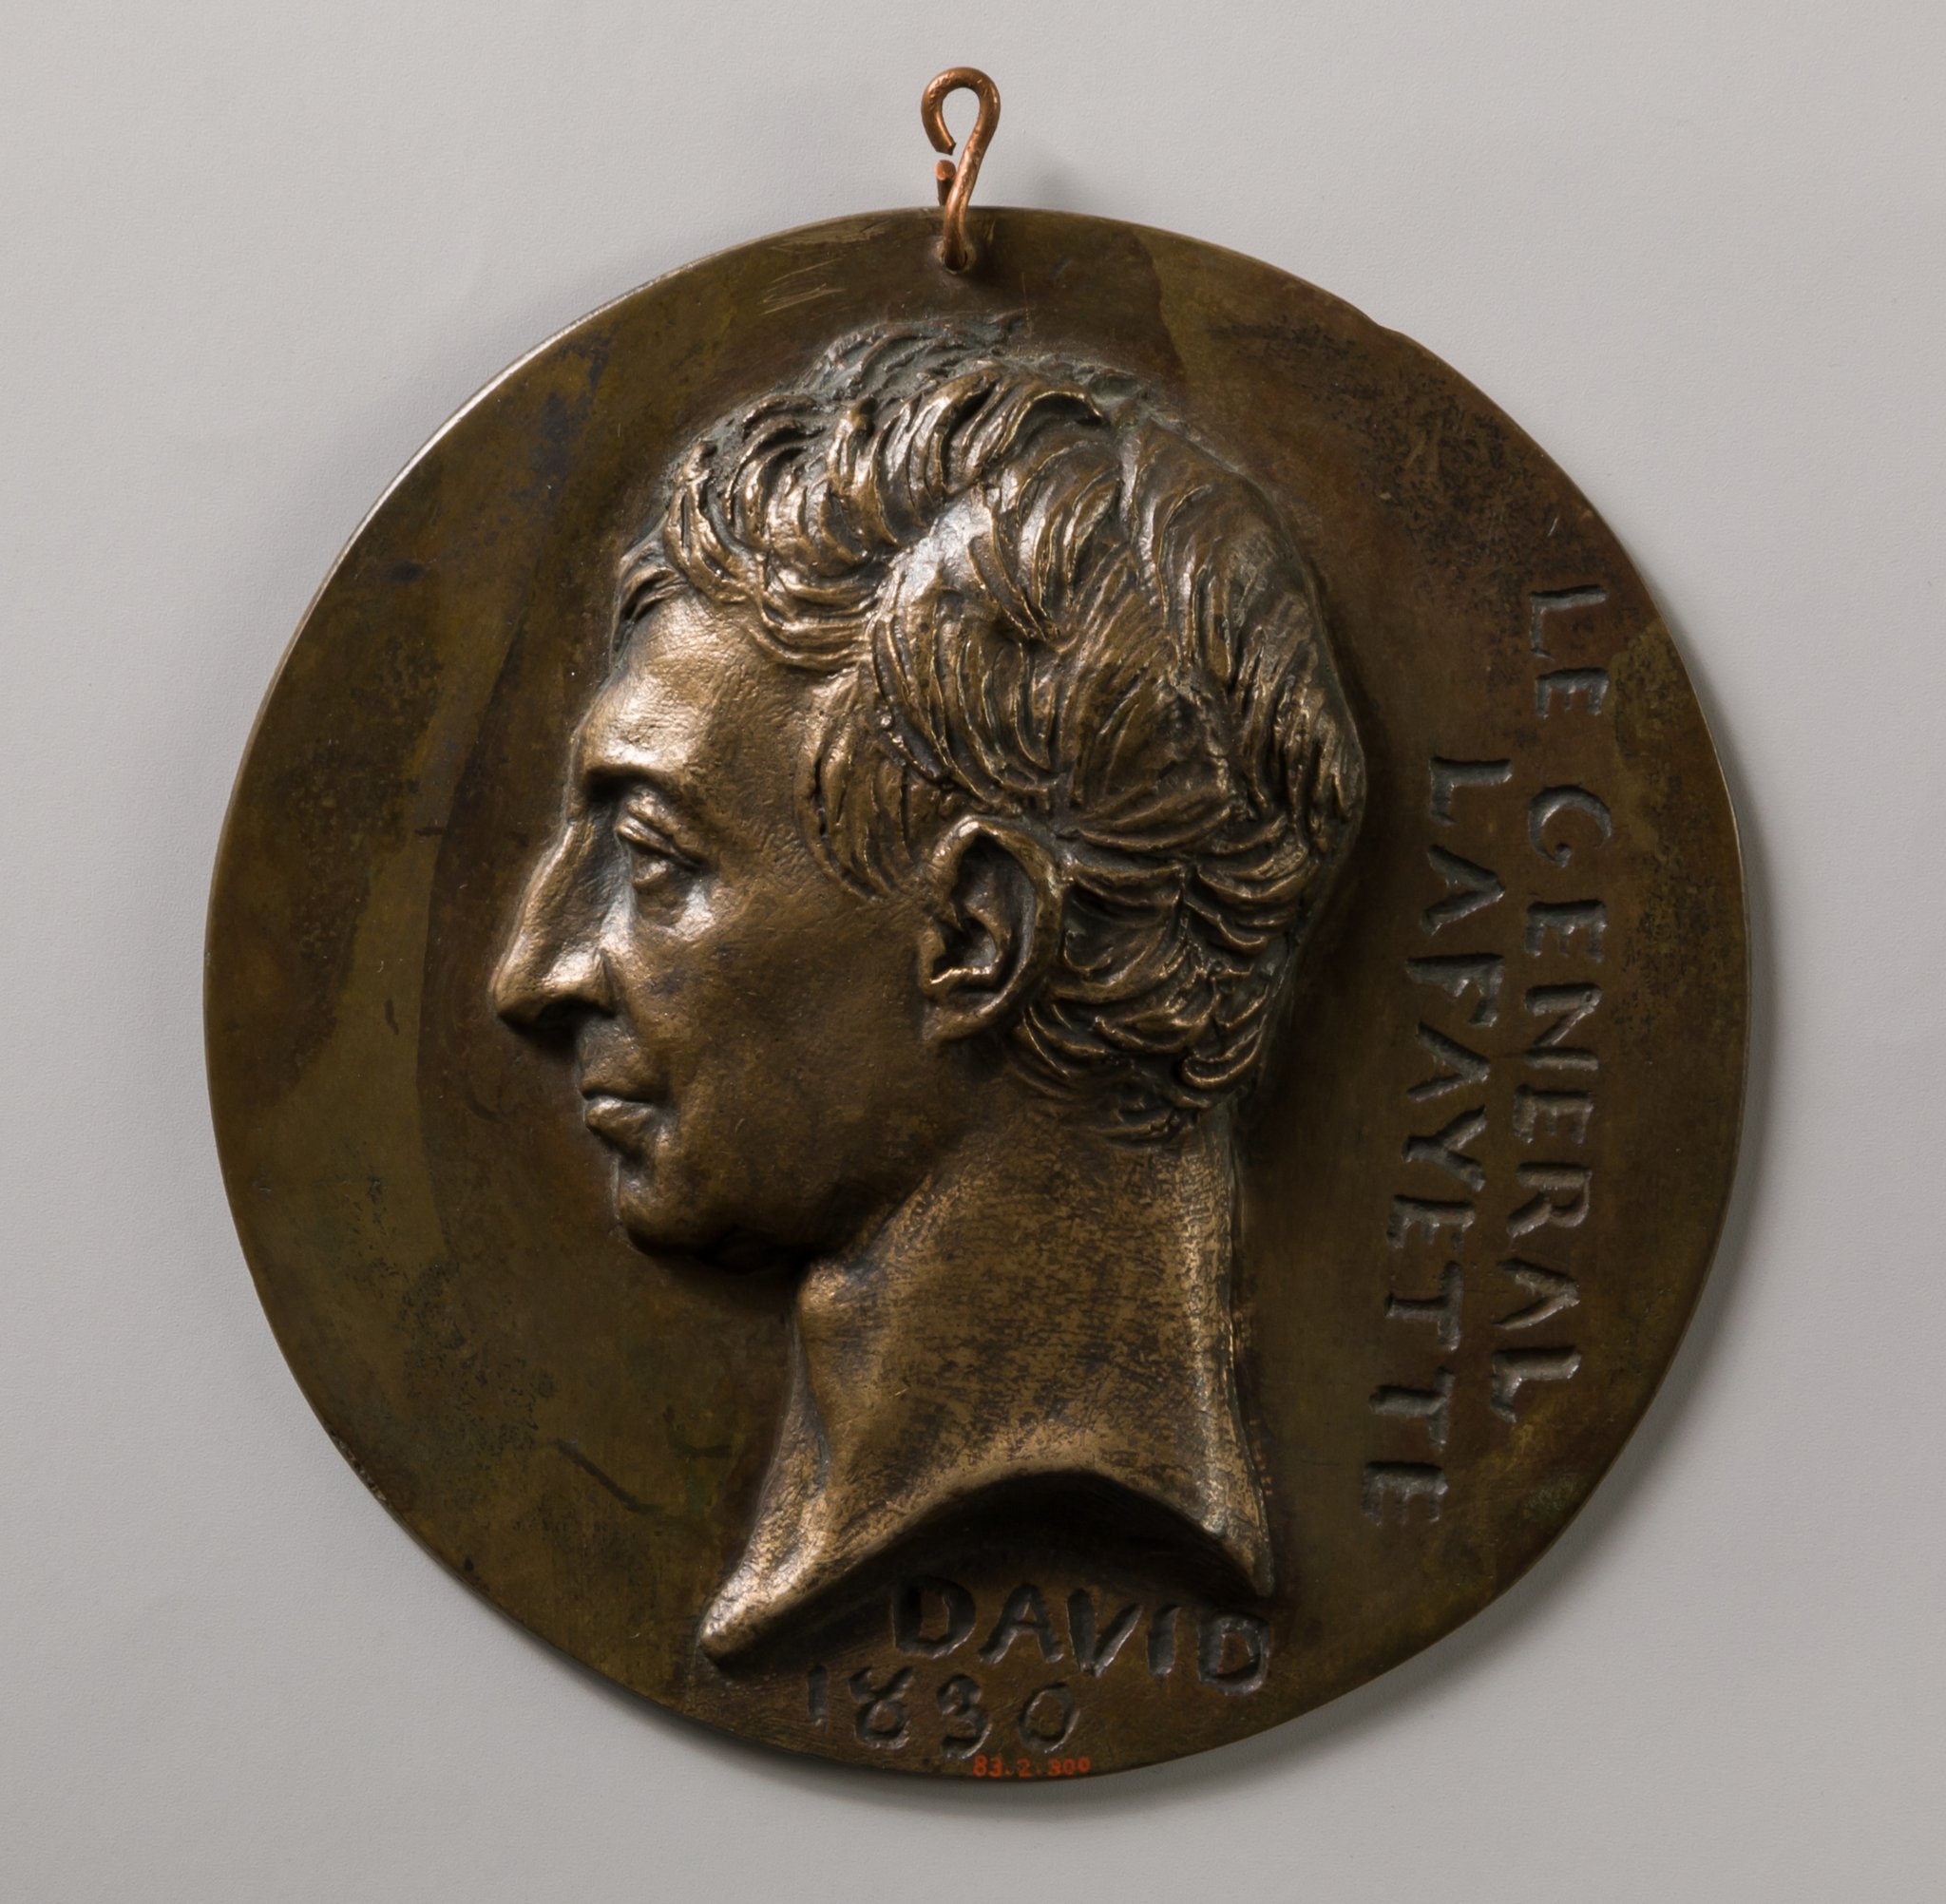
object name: medallion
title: Medallion of the Marquis de Lafayette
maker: pierre jean david d'angers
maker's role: maker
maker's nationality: french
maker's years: 1788-1856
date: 1830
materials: bronze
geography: france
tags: men,profiles,marquis de lafayette